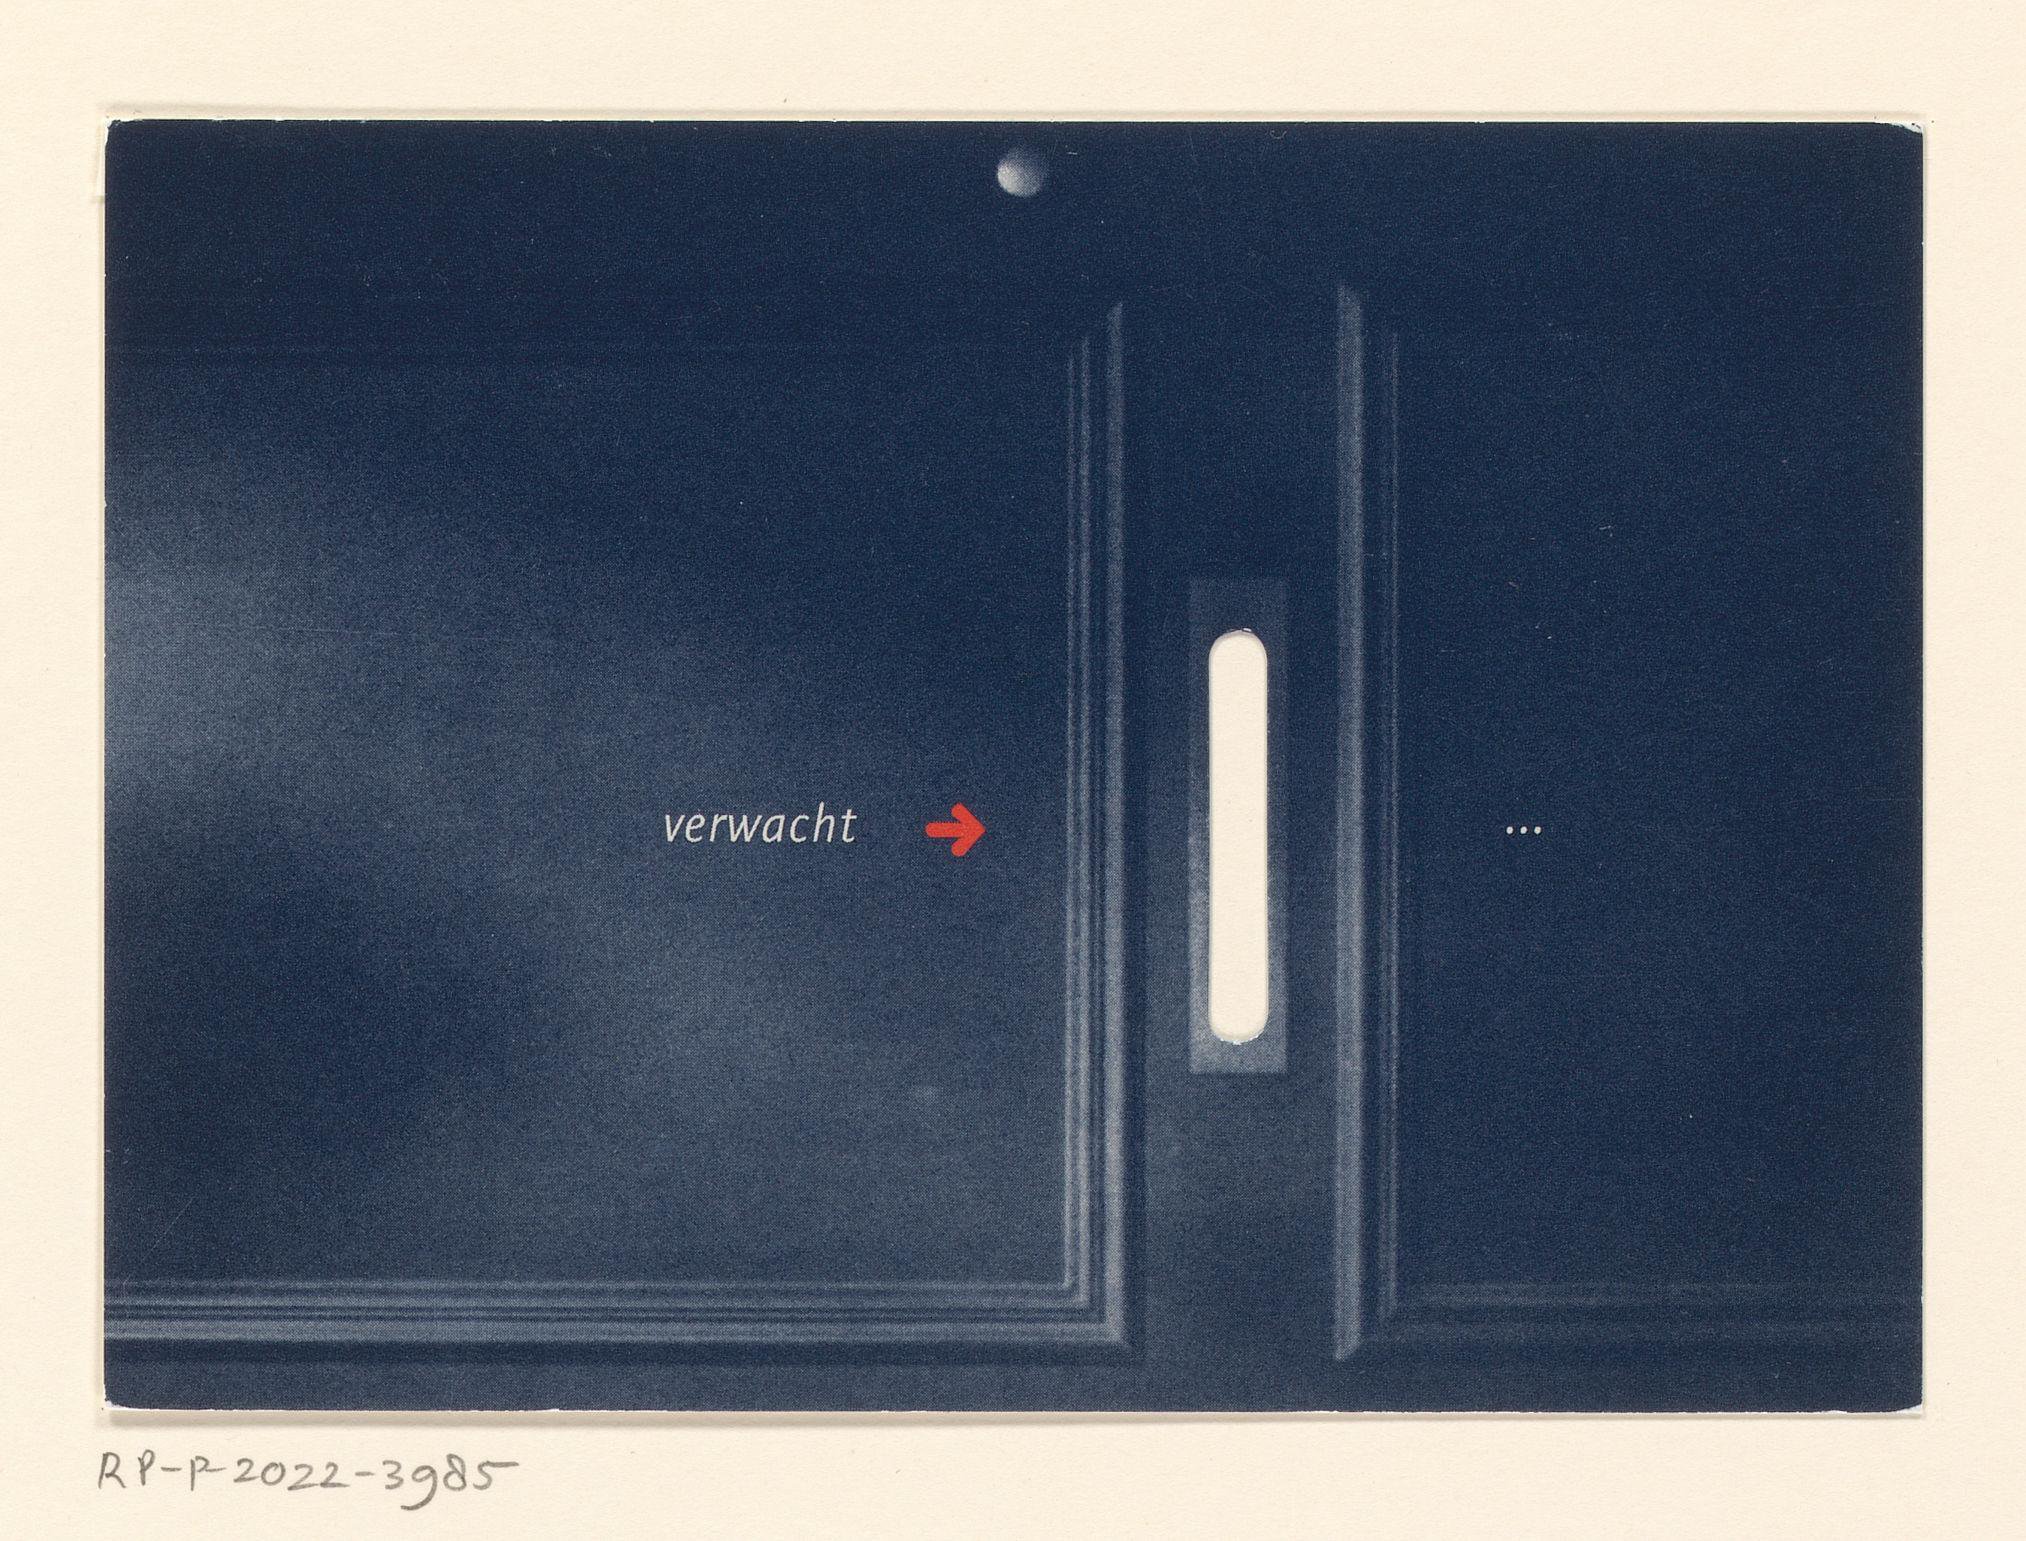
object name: christmas card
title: Kerst- en Nieuwjaarskaart voor 2001 van Neon, Amsterdam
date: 2000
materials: paper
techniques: offset printed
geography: amsterdam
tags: delivering; receiving (~ postal matter), christmas card, january 1 (~ festivities)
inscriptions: collector's mark: Lugt 2228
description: Kerst- en Nieuwjaarskaart voor 2001 van Neon, bureau voor grafische vormgeving, Amsterdam. Brievenbus. Geadresseerd aan directeur Ronald de Leeuw.